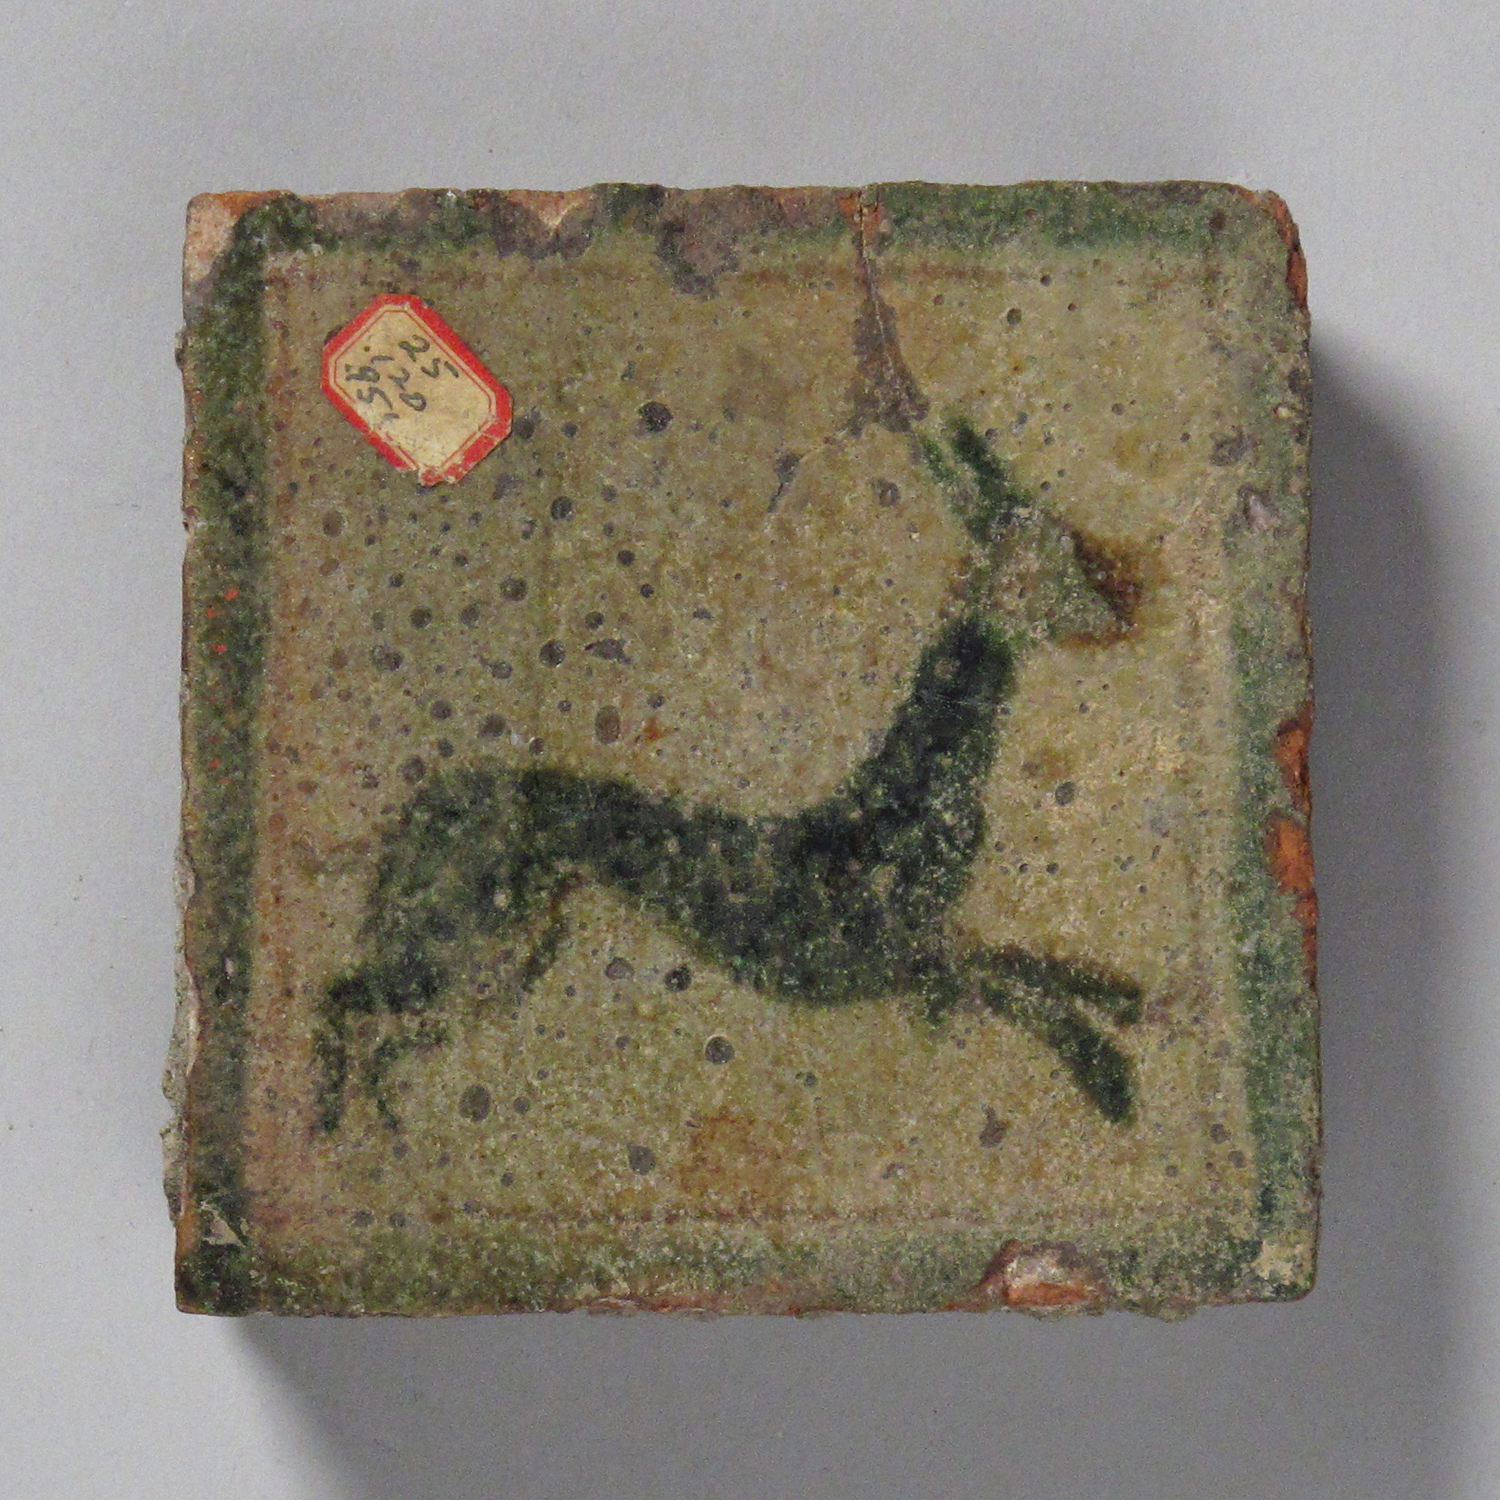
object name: tile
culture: french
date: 1101-1400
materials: earthenware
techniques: glazing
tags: animals